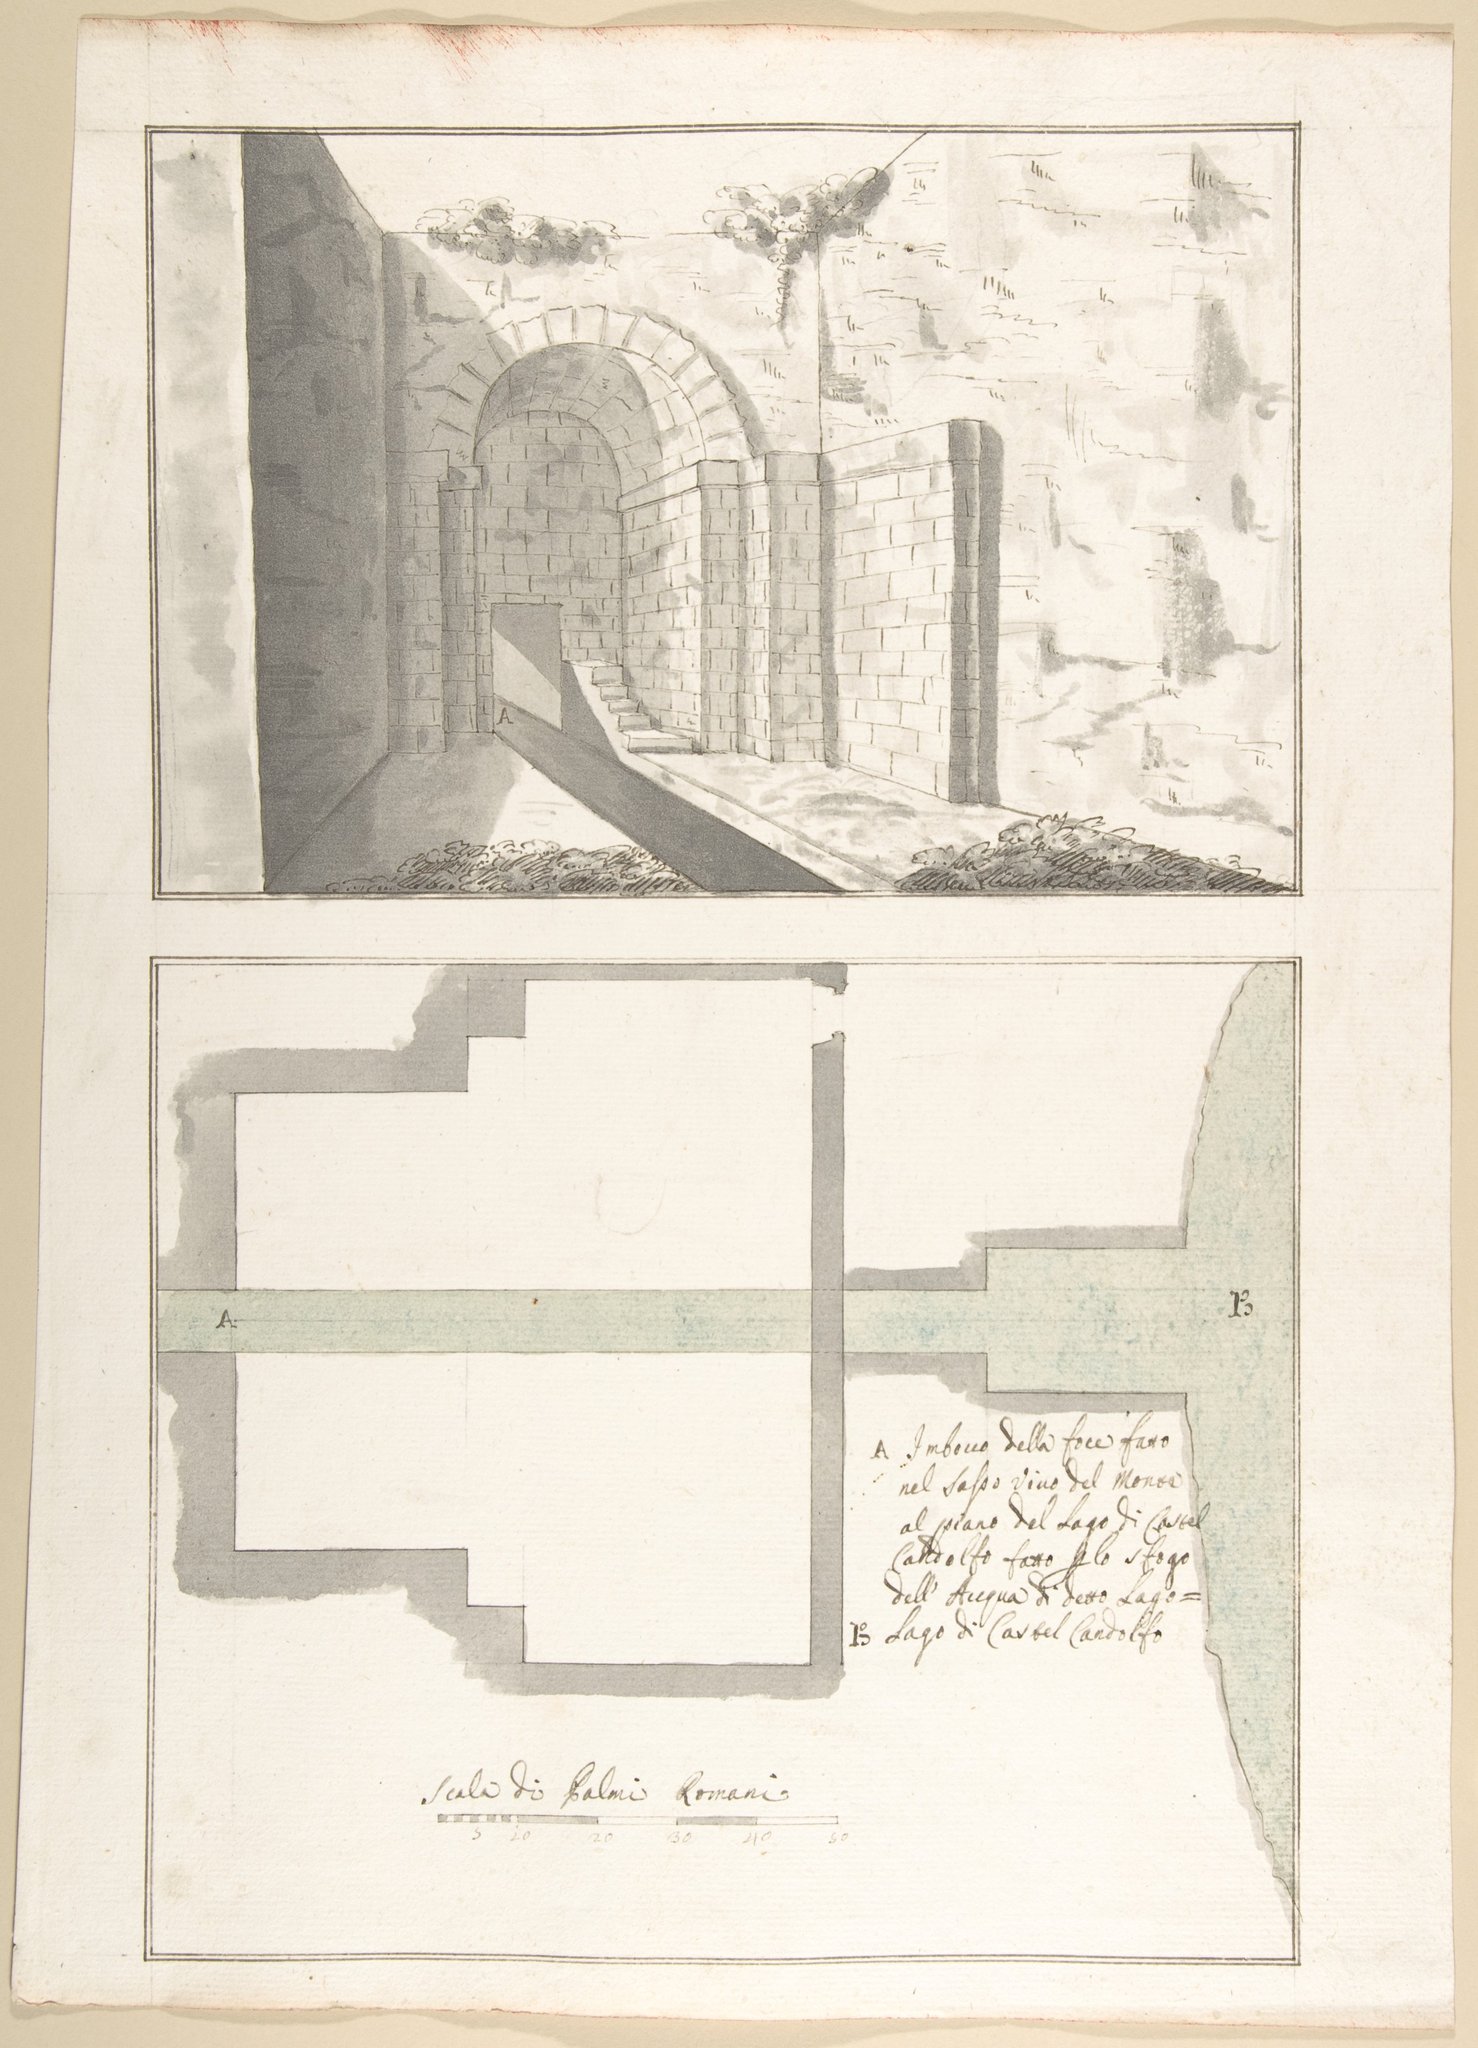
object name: drawing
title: Canalization of the Mouth of the Sasso Vino into the Lake of Castel Gandolfo: Perspective and Plan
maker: pietro paolo coccetti (cocchetti)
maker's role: artist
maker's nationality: italian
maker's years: 1710-1727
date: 1710-1727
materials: graphite, ink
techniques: brush, pen, wash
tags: architecture,canals